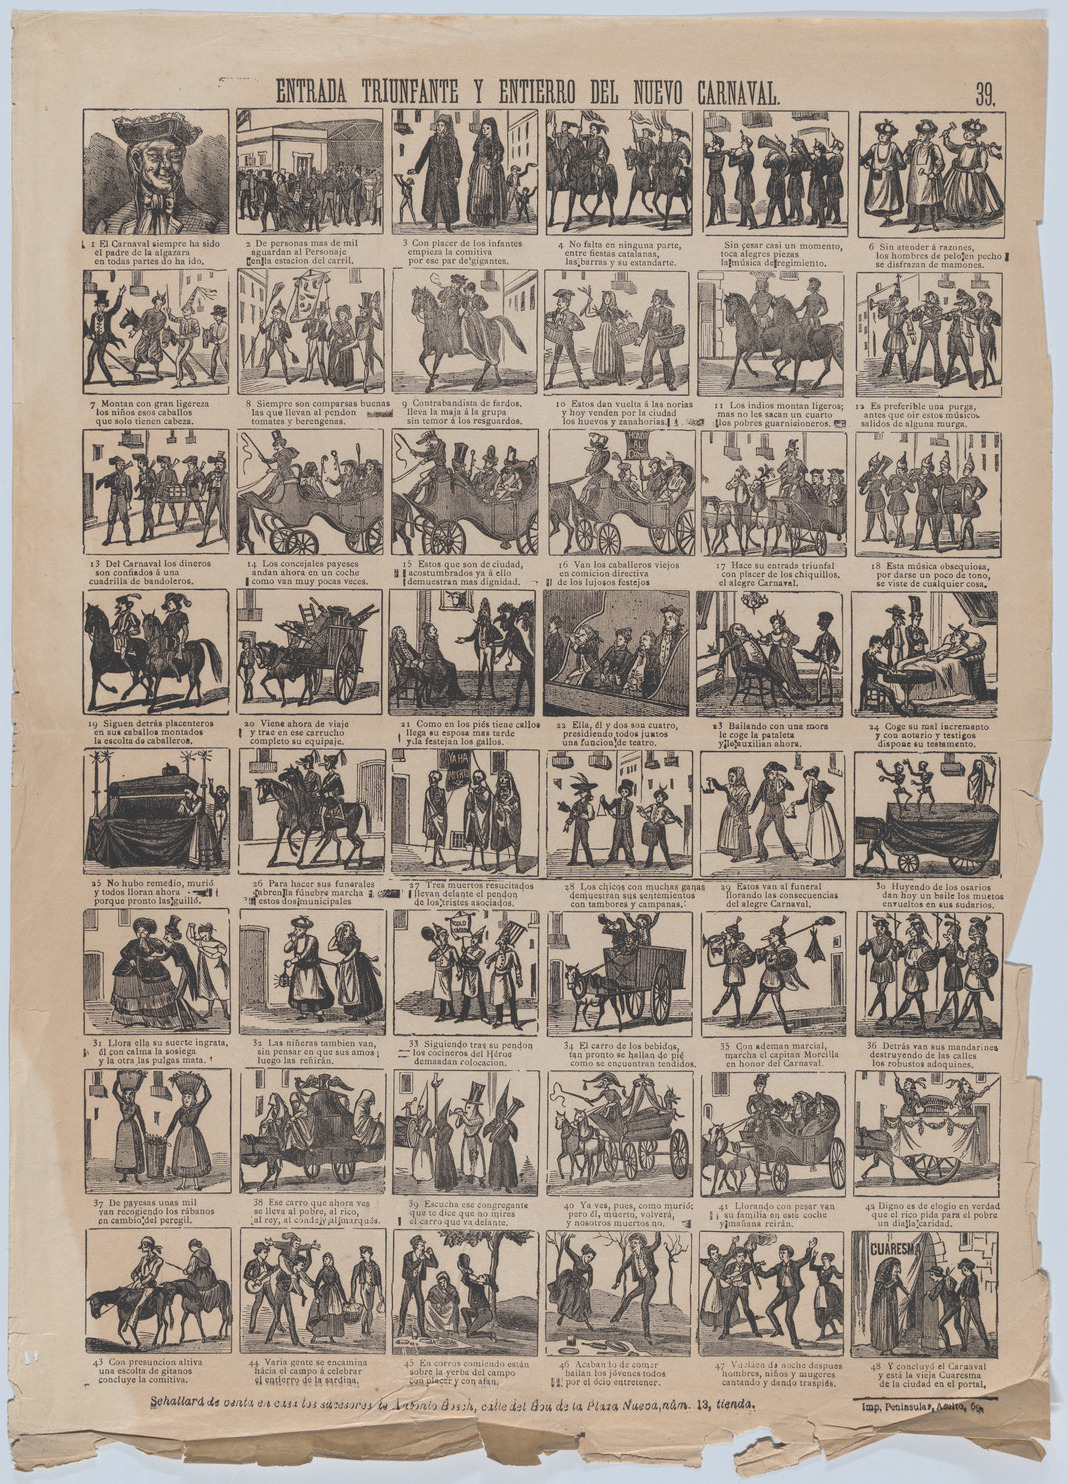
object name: print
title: Broadside with 48 scenes depicting the triumphal entry and burial and entry of the new carnival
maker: antonio bosch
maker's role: publisher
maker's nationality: spanish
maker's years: 1860-1880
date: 1860-1870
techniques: lithograph, engraving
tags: men,women,horses